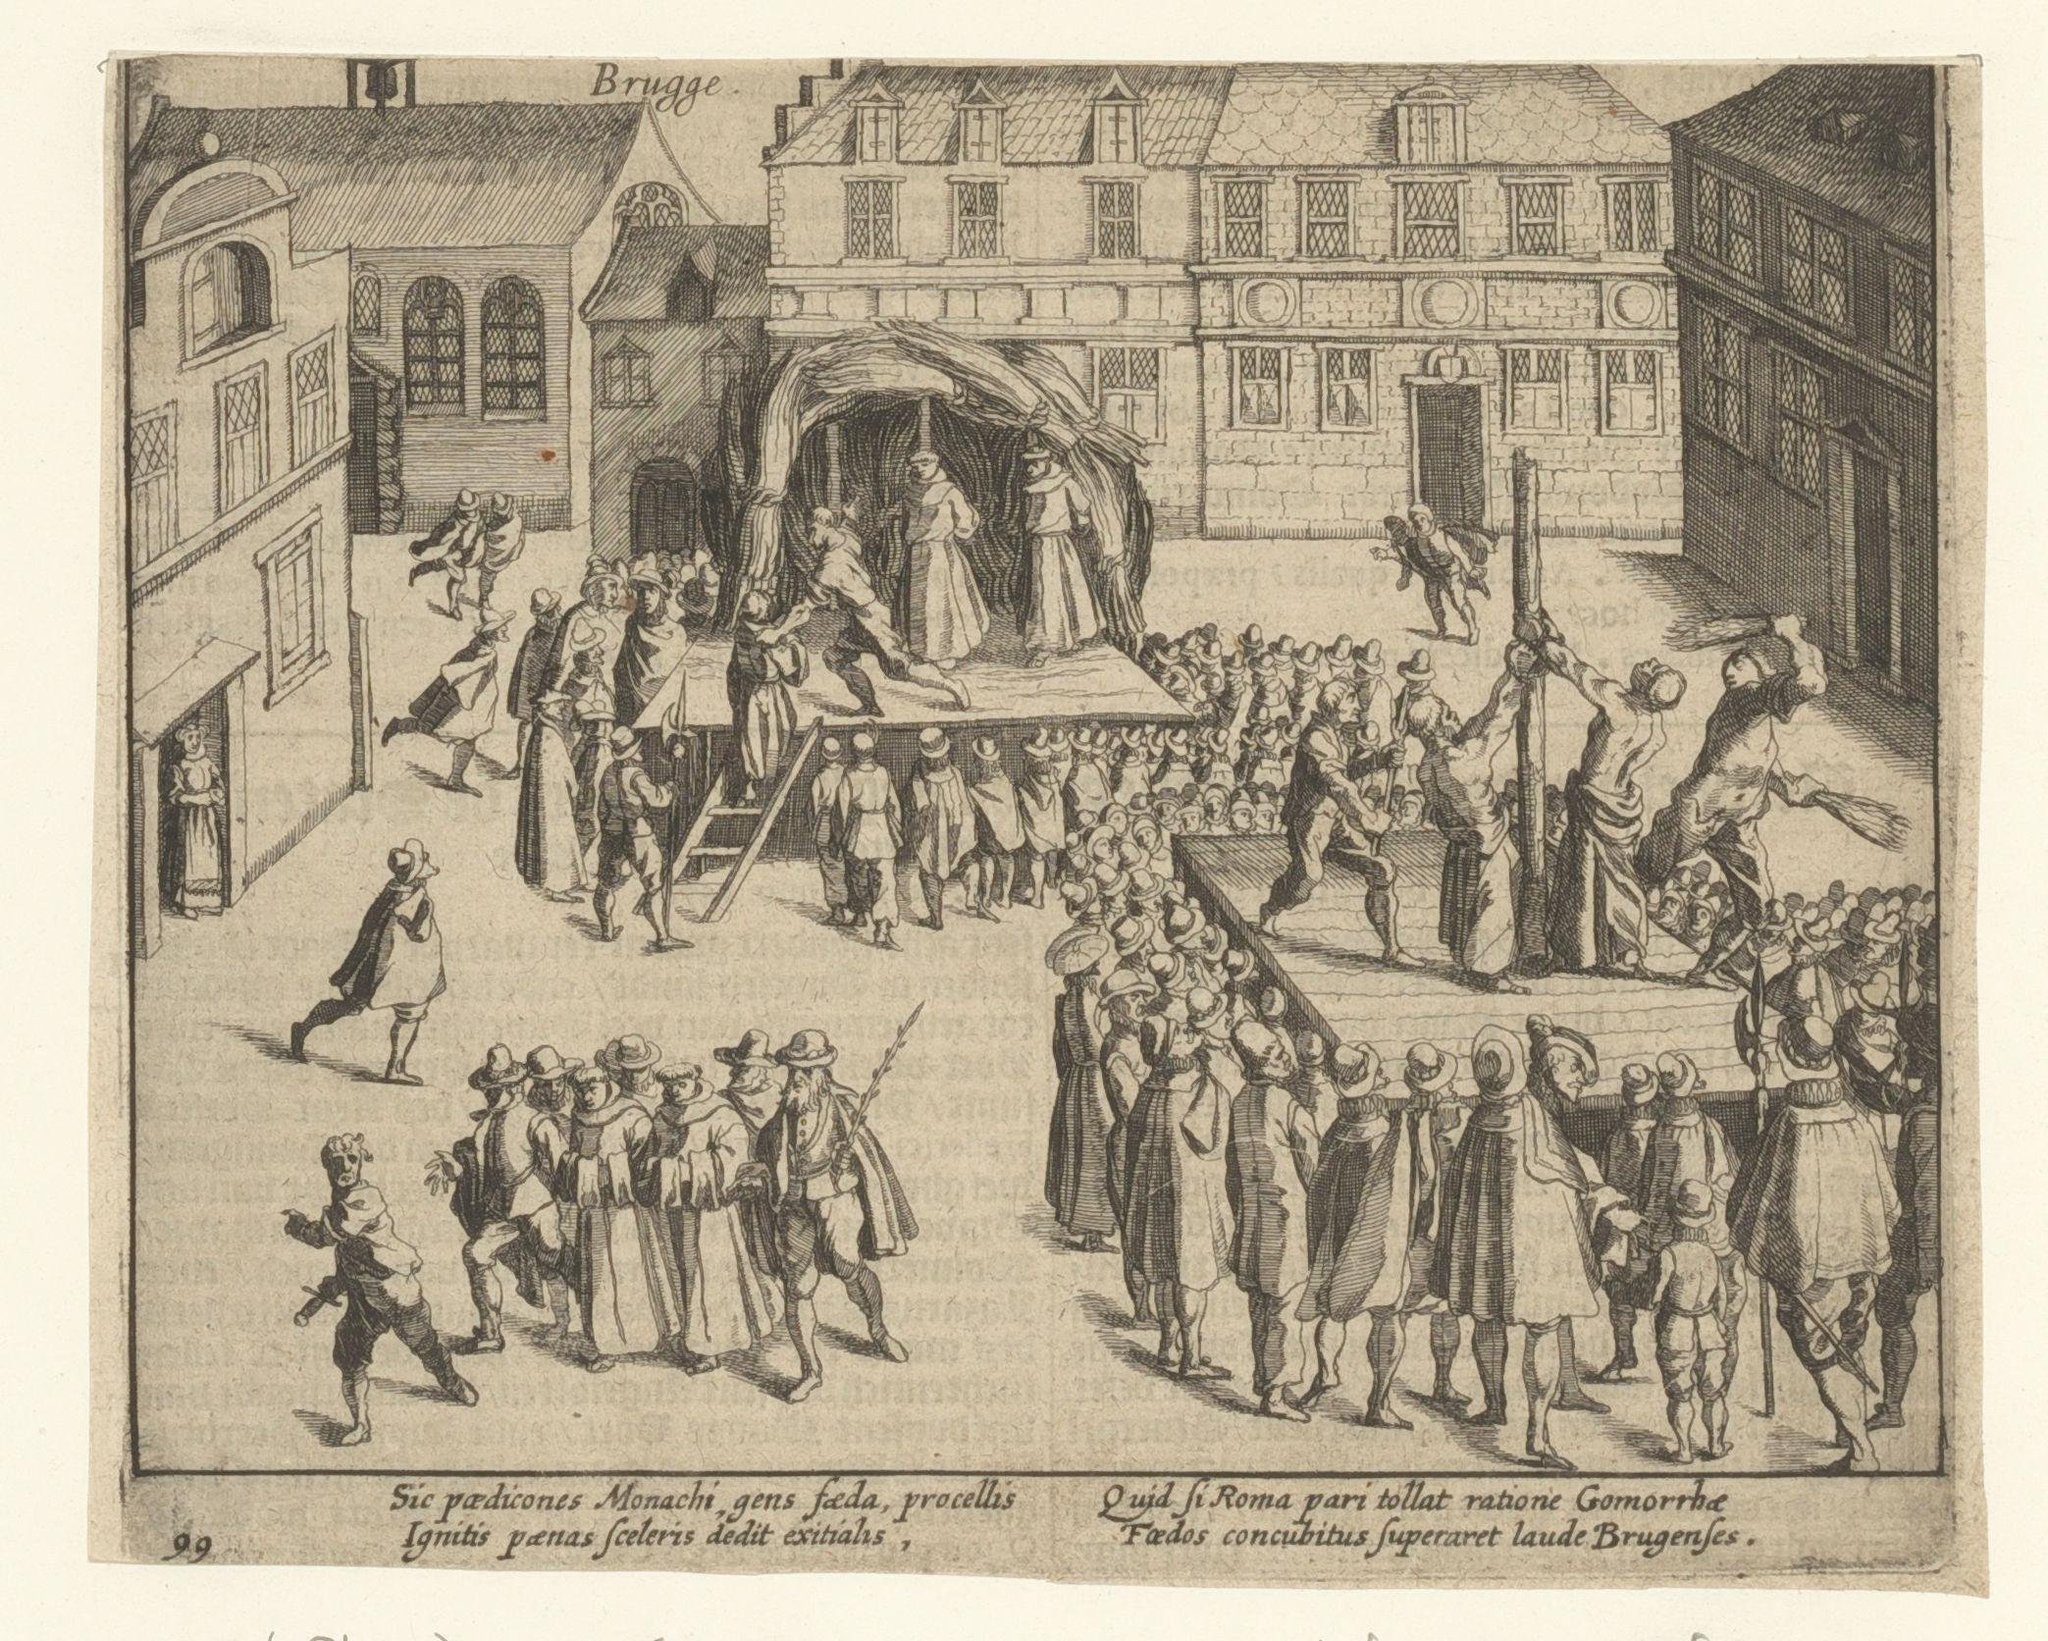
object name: print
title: Brugse monniken op de brandstapel, 1578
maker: simon frisius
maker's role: print maker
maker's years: 1570-1628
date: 1616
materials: paper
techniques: etching, letterpress printing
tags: sodomy, sexual contact between men, law and jurisprudence, bruges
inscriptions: collector's mark: Lugt 1641, stamp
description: Geseling en terechtstelling van de franciscaner monniken te Brugge op beschuldiging van sodomie, 26 juli 1578. Rechts de geseling, links de monniken op de brandstapel. Onderaan een vierregelige tekst in het Latijn. Linksonder genummerd: 99. Onderwerpsrubrieken binnen de Atlas Zeden en Gewoonten: Regeering, Rechtswezen.